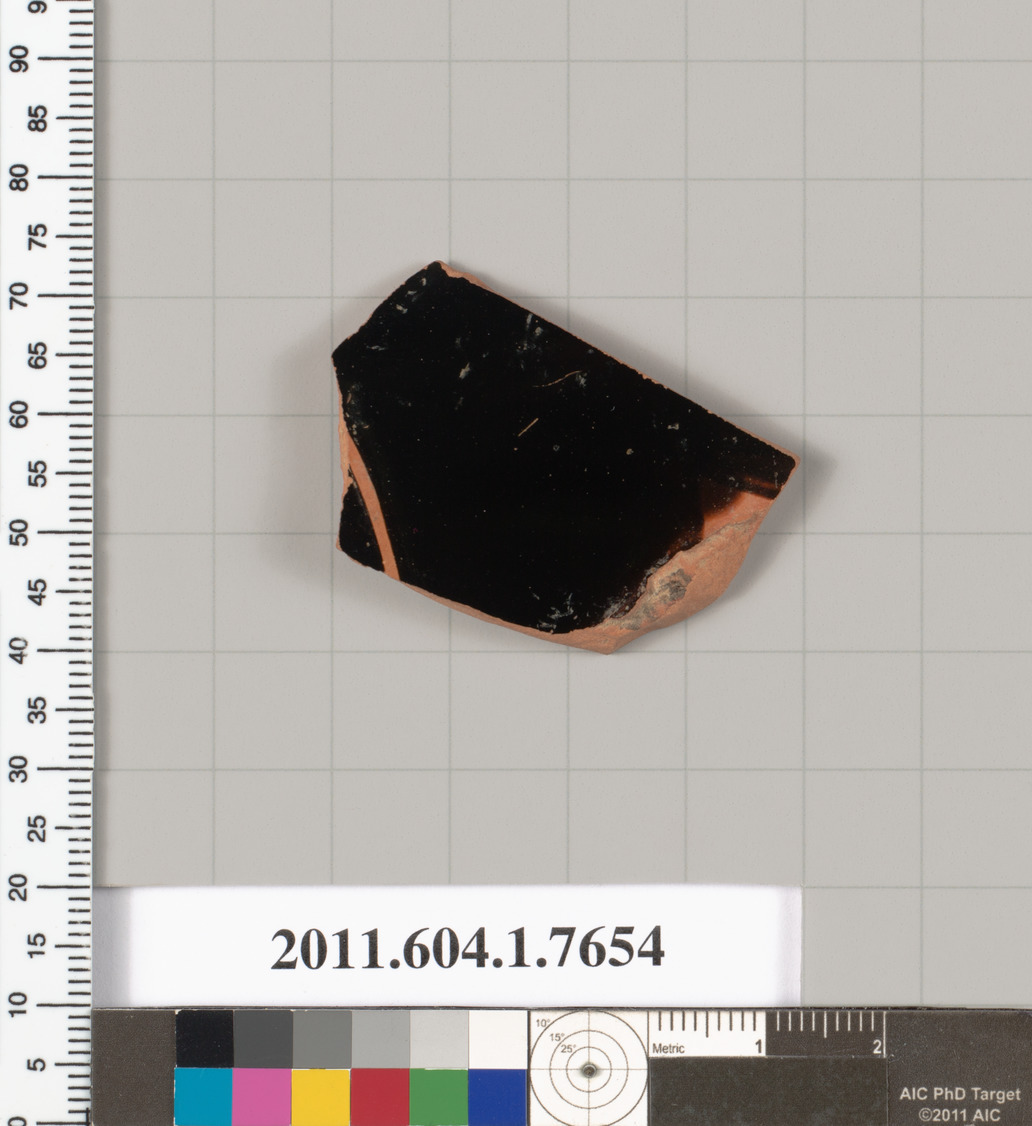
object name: kylix fragment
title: Terracotta fragment of a kylix (drinking cup)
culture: greek, attic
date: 460-450 BCE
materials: terracotta